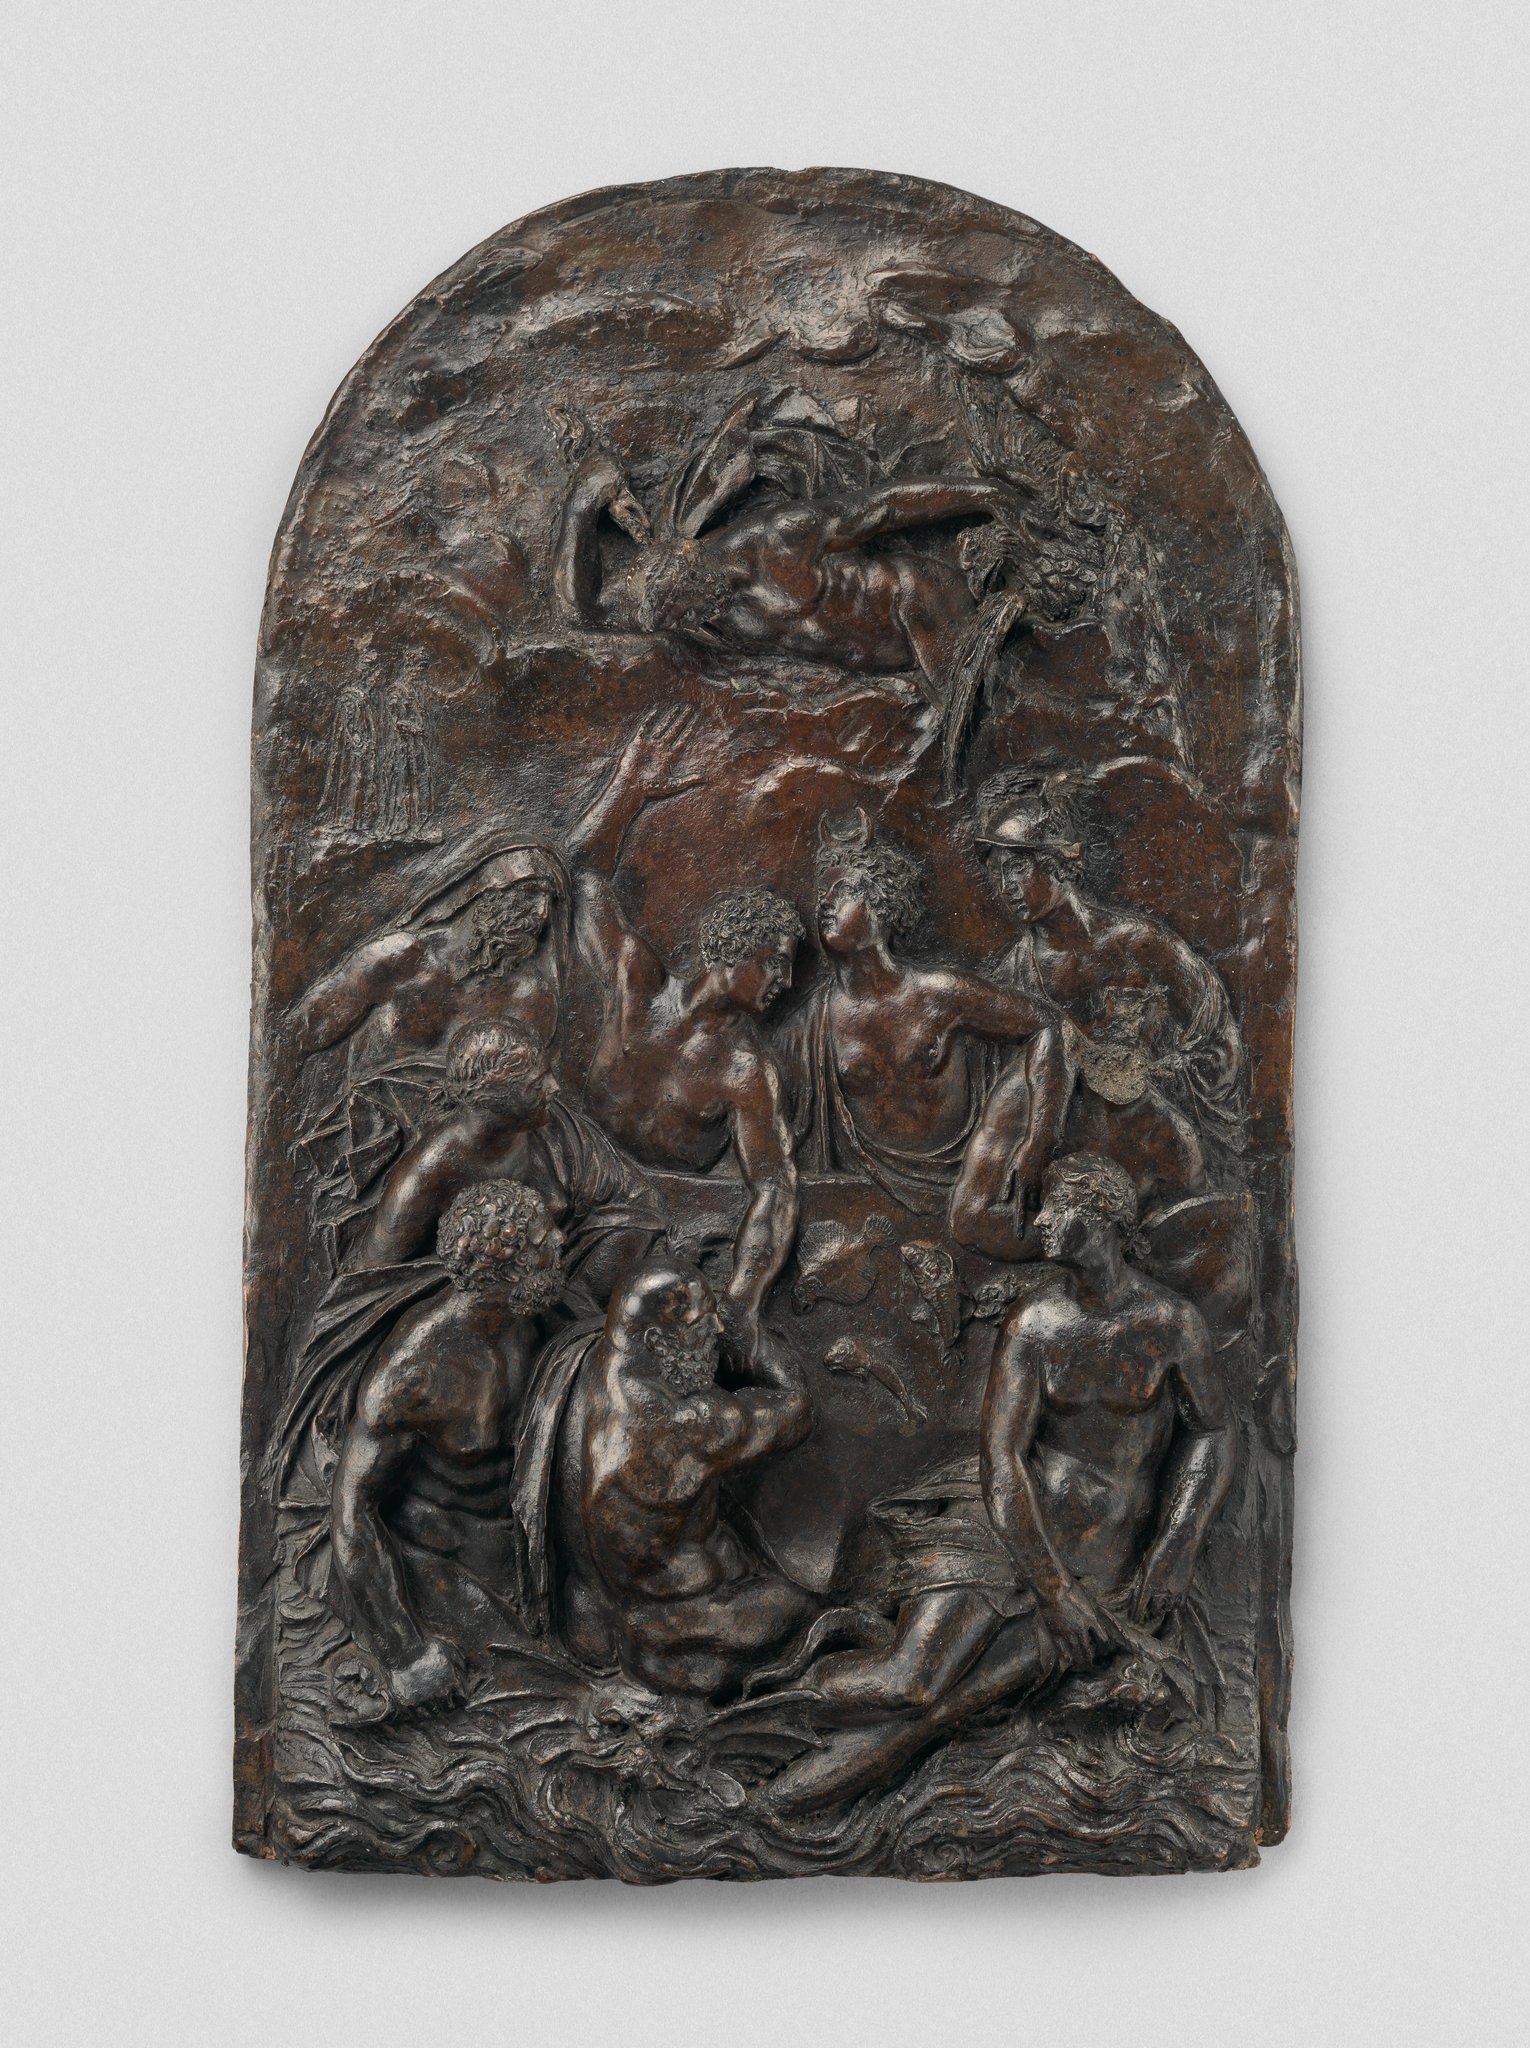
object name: plaque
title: Banquet of the gods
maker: alessandro vittoria (alessandro vittoria di vigilio della volpa)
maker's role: artist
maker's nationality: italian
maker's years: 1525-1608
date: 1501-1600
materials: bronze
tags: men,women